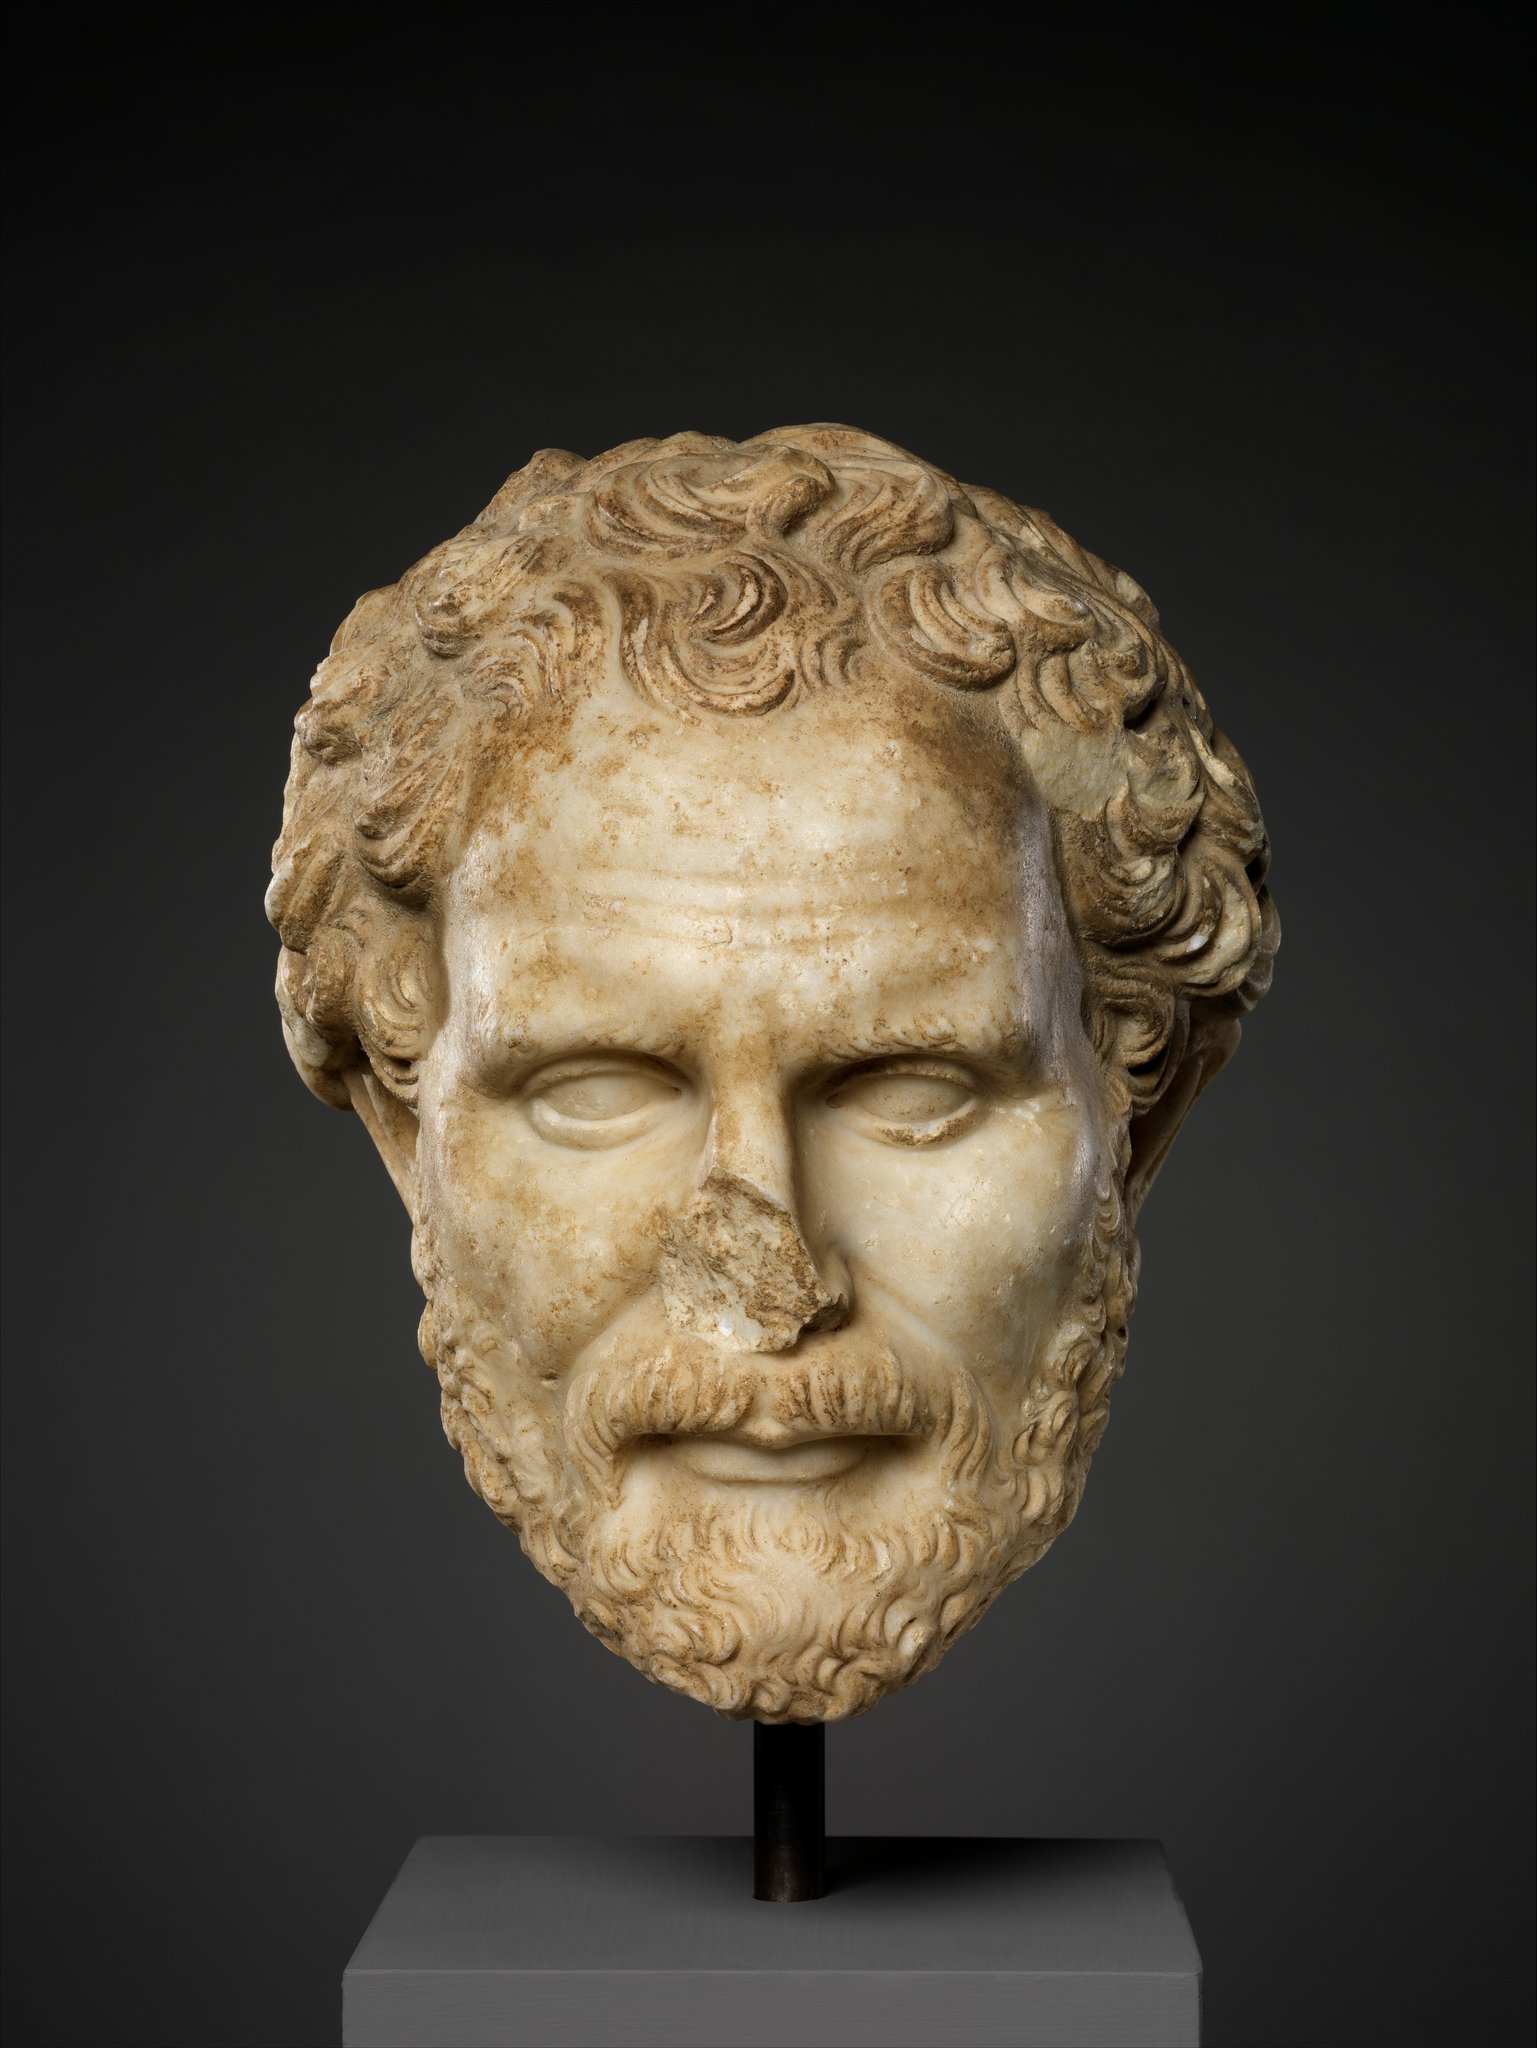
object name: head of demosthenes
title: Marble head of Demosthenes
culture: roman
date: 101-200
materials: marble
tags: heads,men